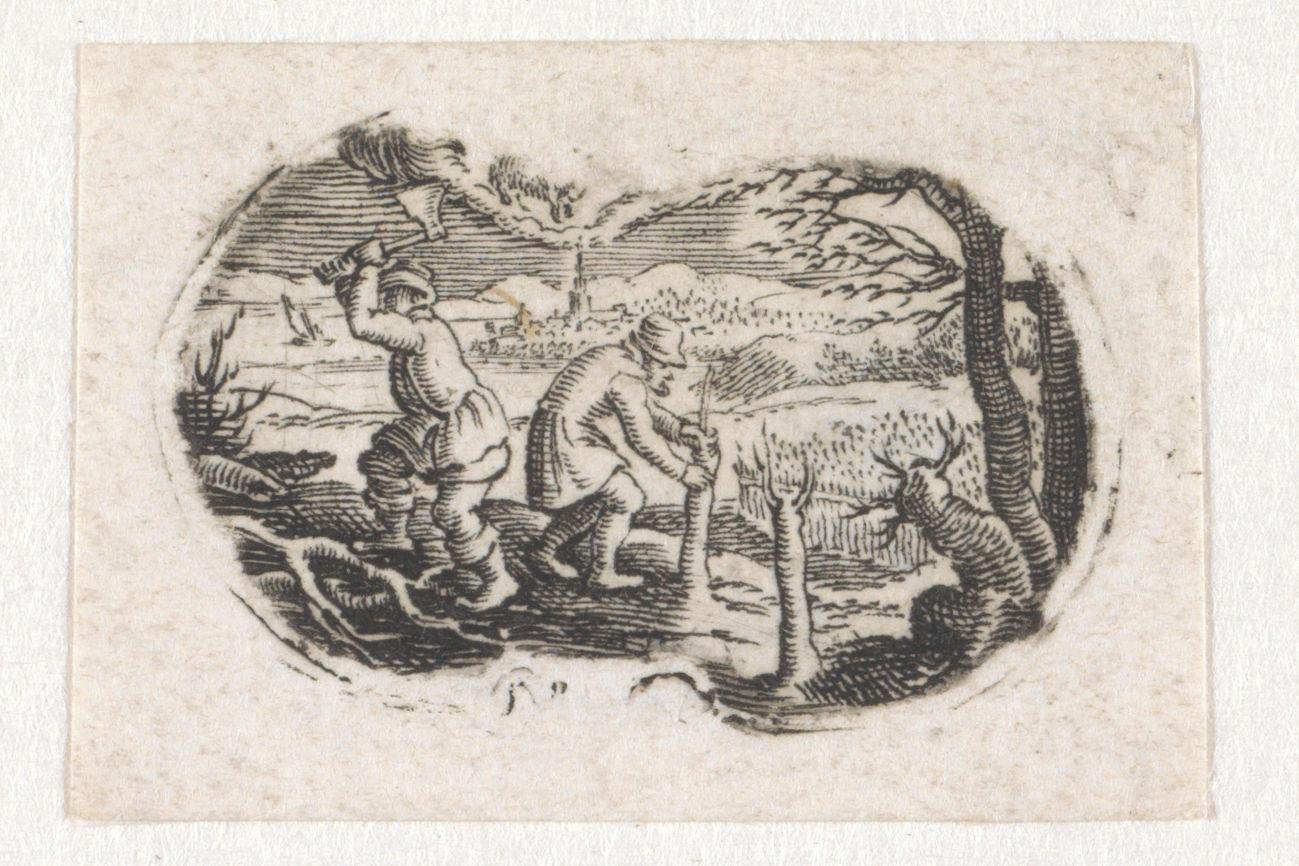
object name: print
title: Maart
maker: Anonymous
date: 1625-1700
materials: paper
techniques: engraving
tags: woodcutting, woodcutter ~ forestry, march and its 'labours', aries (zodical sign of march)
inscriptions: collector's mark: Lugt 2760, collector's mark: Lugt 2228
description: Menselijke bezigheden in de maand maart. Landschap met houthakker en een man die een boom ent. Linksboven het sterrenbeeld Ram.